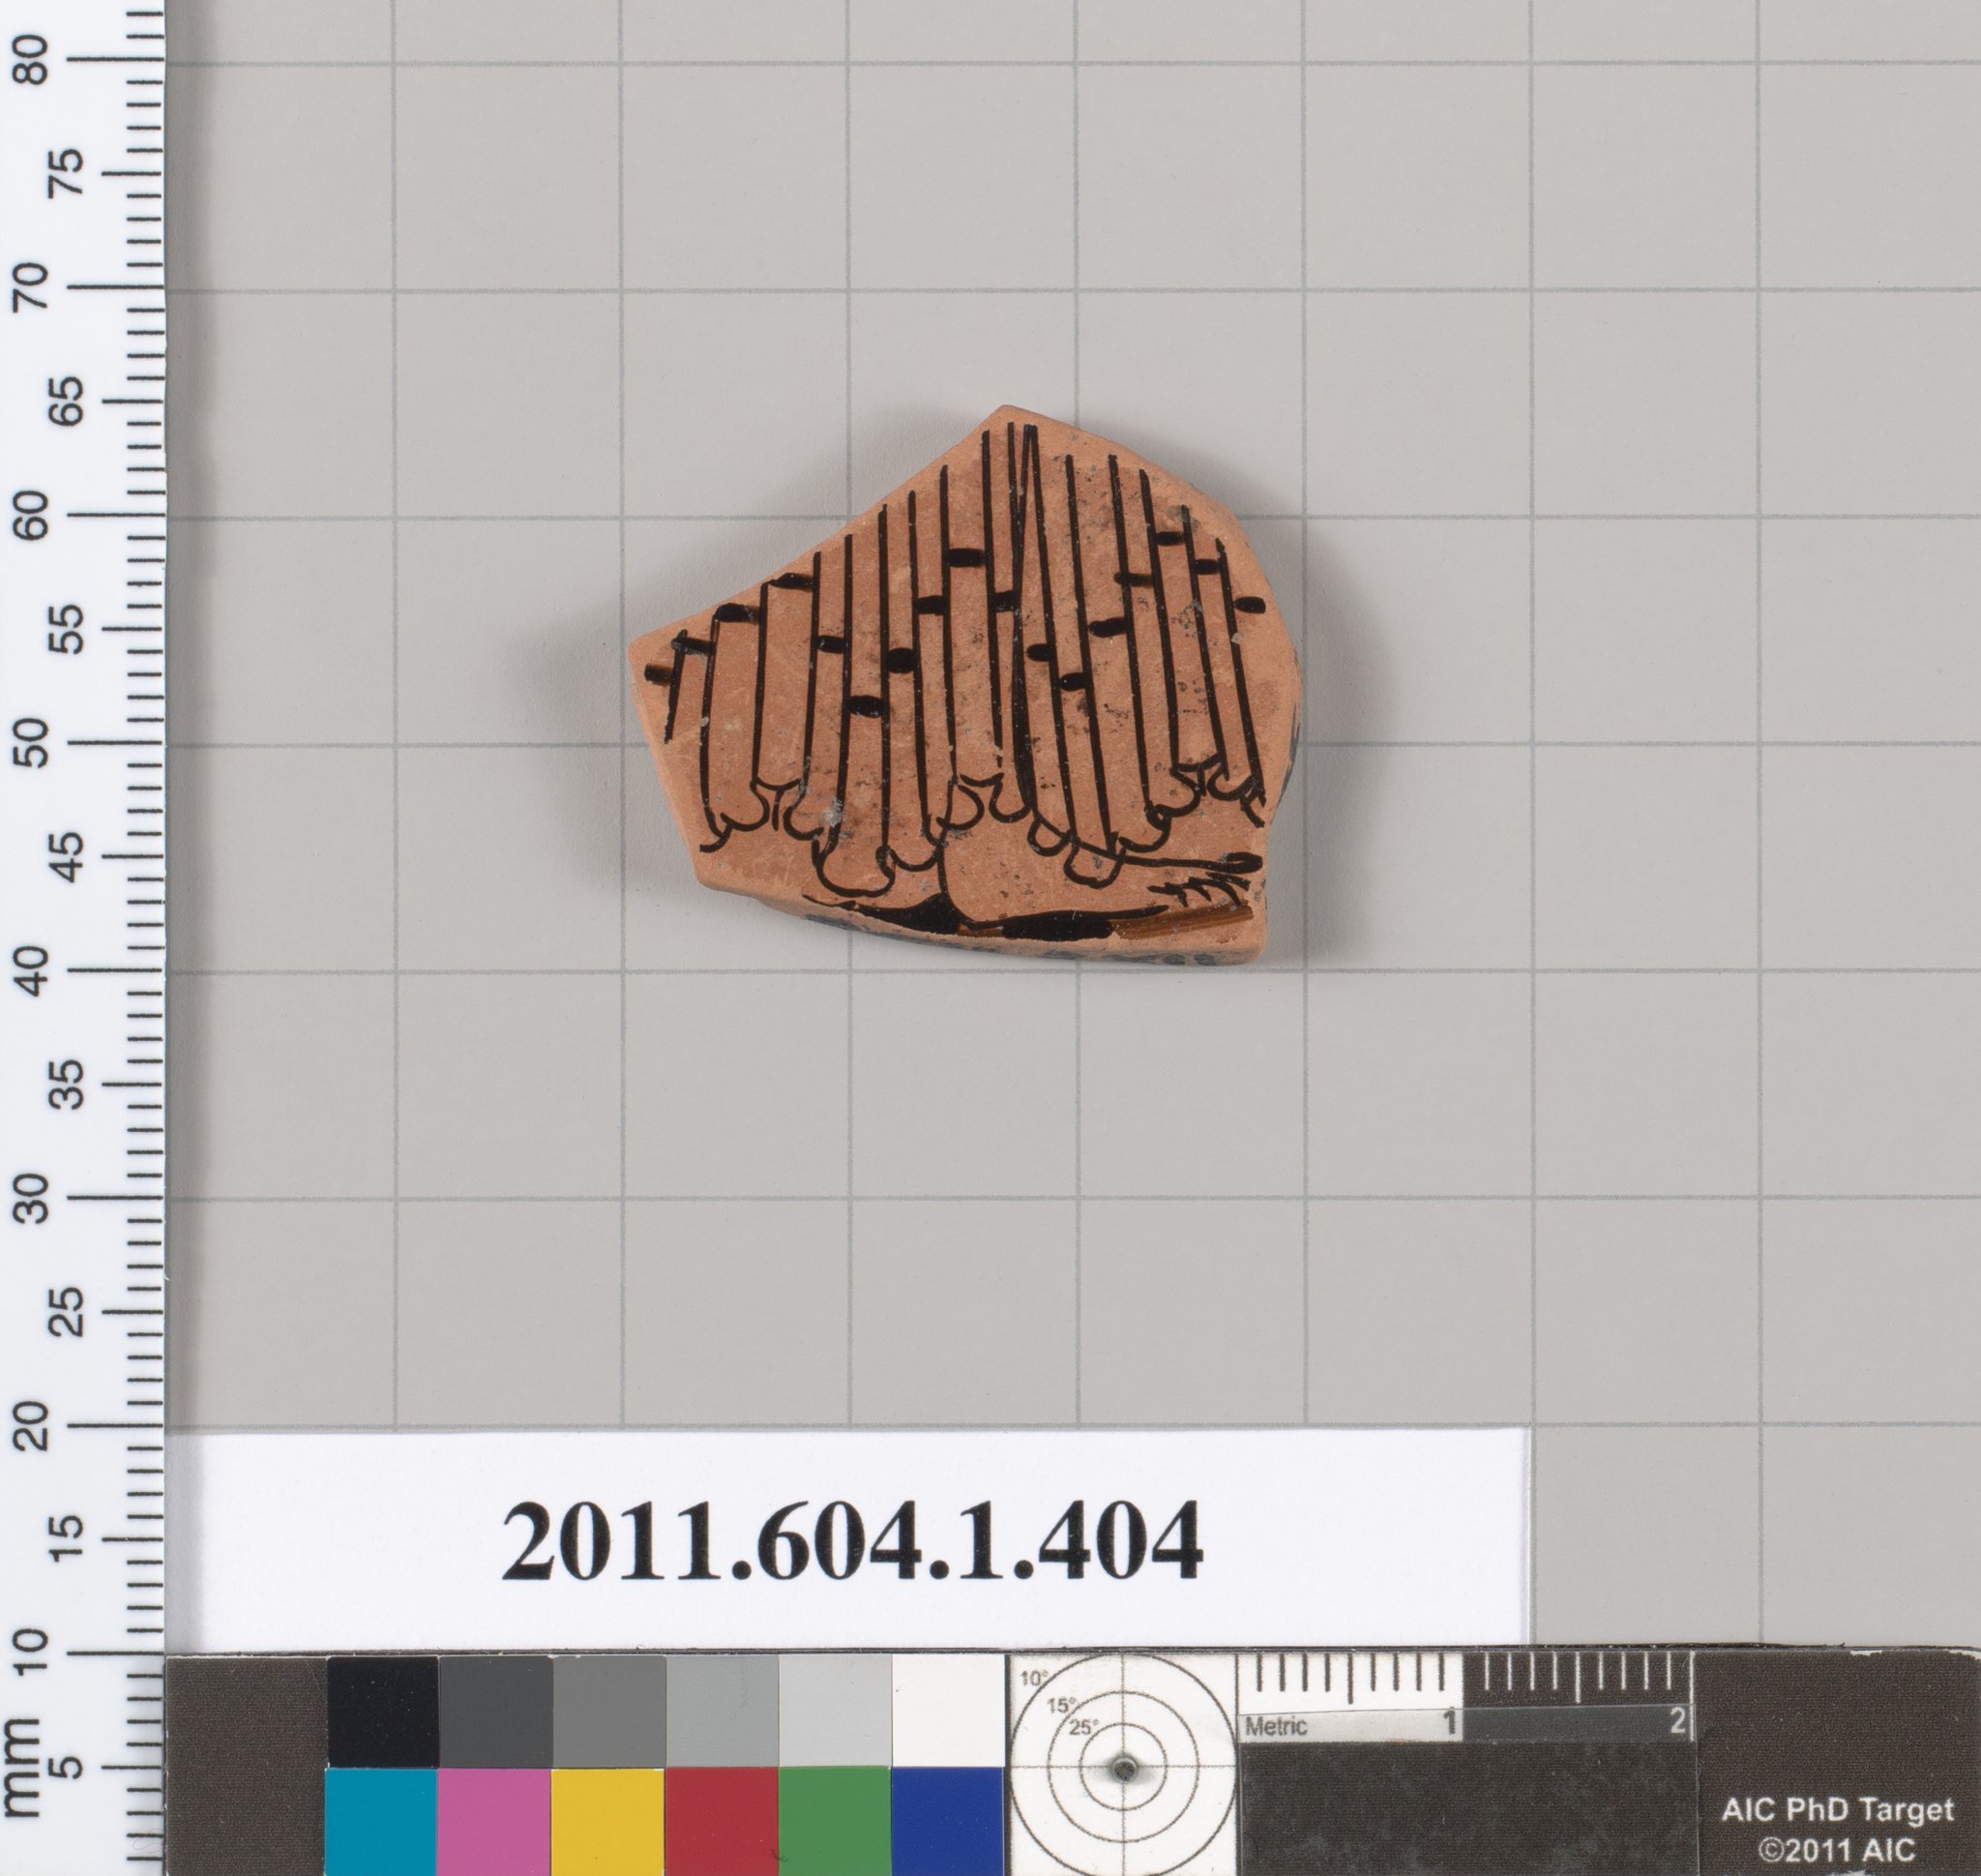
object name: kylix fragment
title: Terracotta fragment of a kylix (drinking cup)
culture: greek, attic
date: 490-480 BCE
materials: terracotta